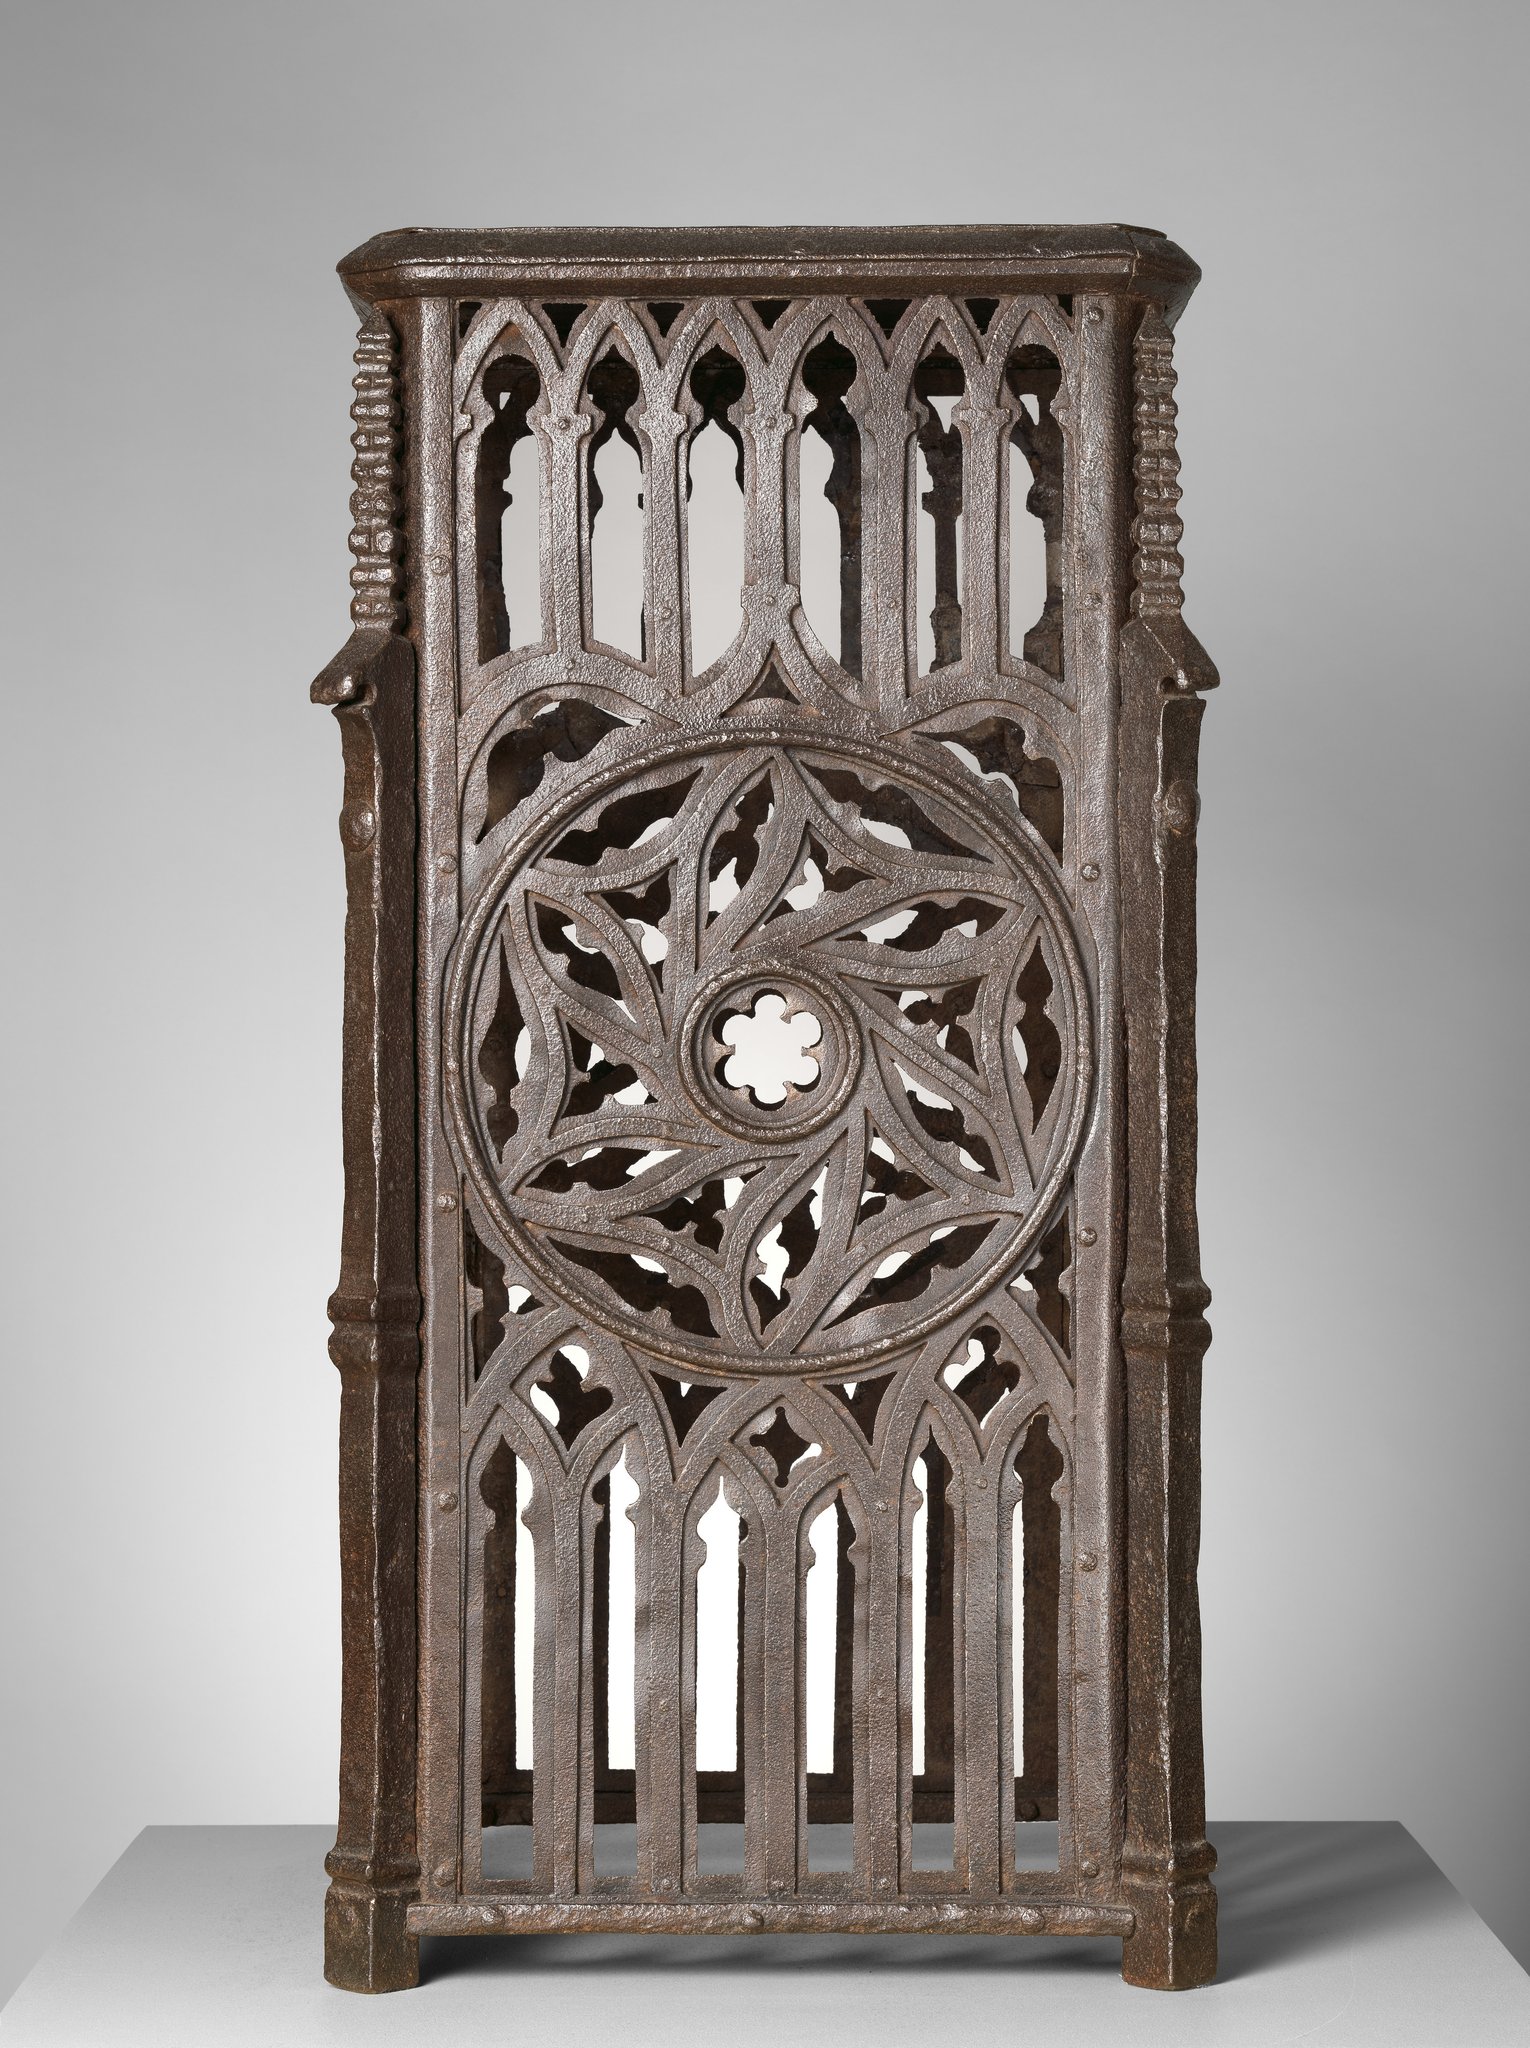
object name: pedestal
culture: central or northern european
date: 1401-1500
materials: iron